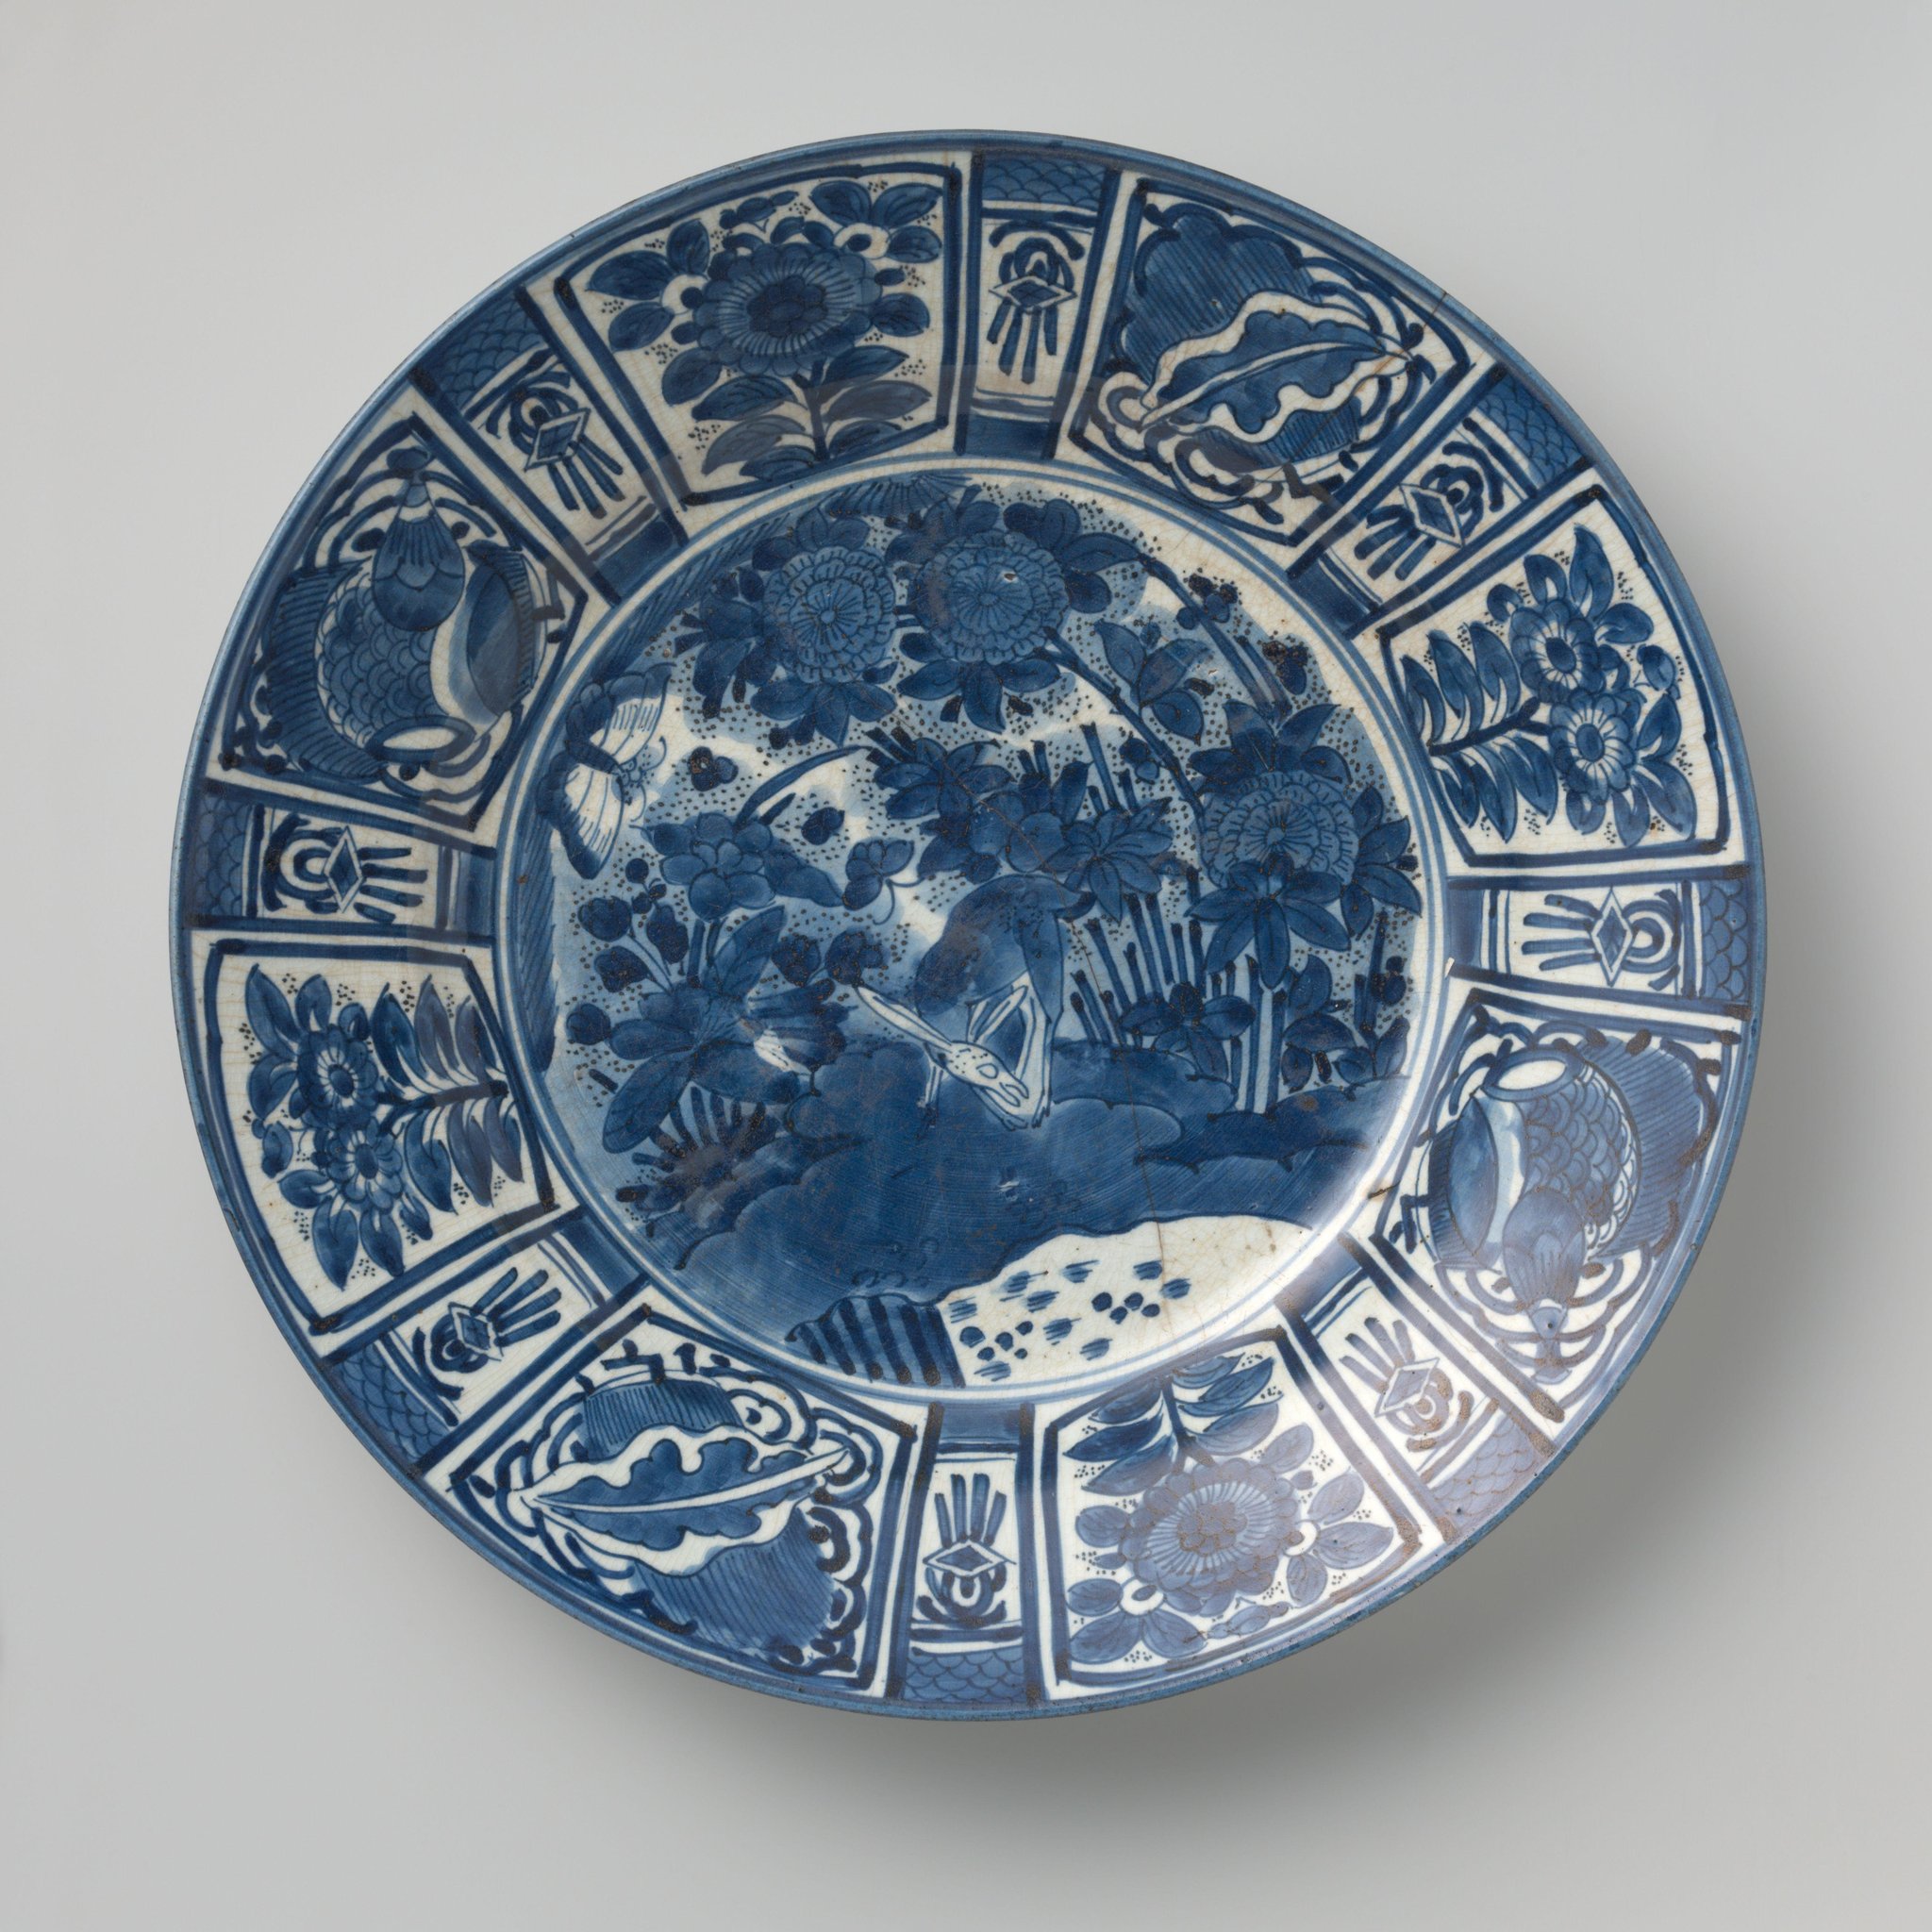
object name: platter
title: Dish with a deer in a landscape and panel decoration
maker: Anonymous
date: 1650-1699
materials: cobalt, glaze, paint, porcelain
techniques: firing, turning, vitrification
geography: japan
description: Tureen with cover. Japan, Arita. Late 17th century. Porcelain, decoration in underglaze blue. Dish. Japan, Arita ca. 1660-1680. Porcelain, decoration in underglaze blue.